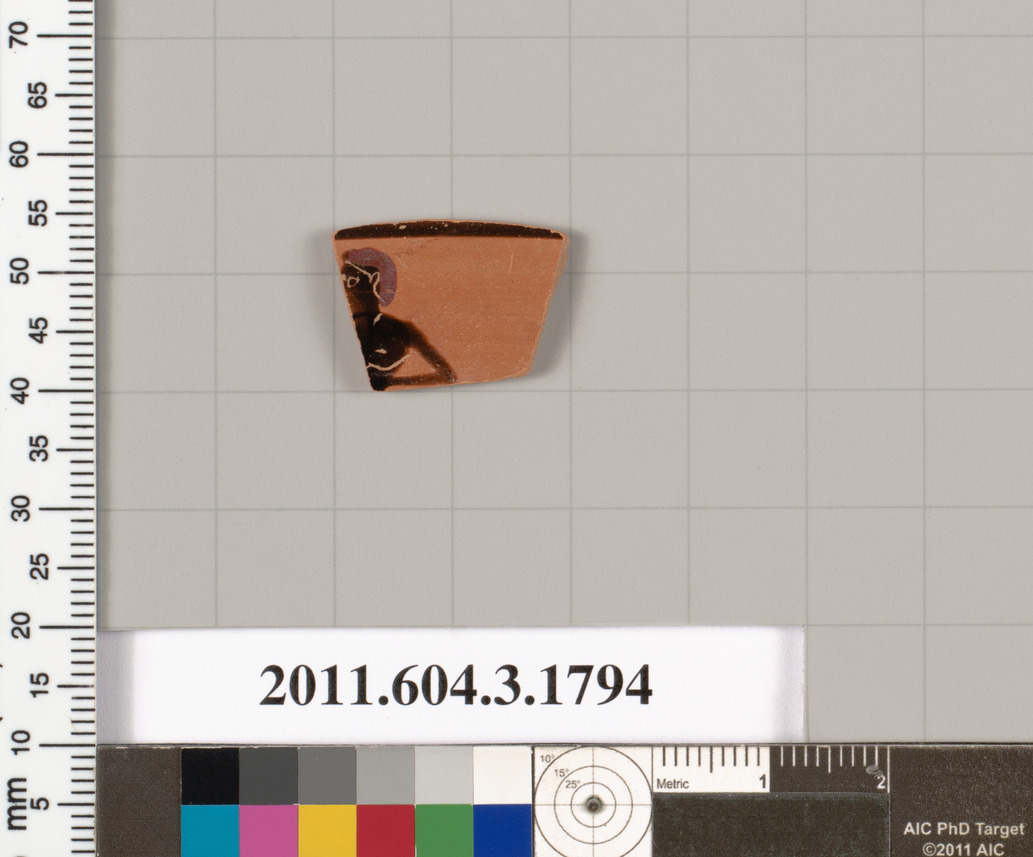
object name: kylix fragment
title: Terracotta fragment of a kylix: Lip cup (drinking cup)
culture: greek, attic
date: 567-535 BCE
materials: terracotta